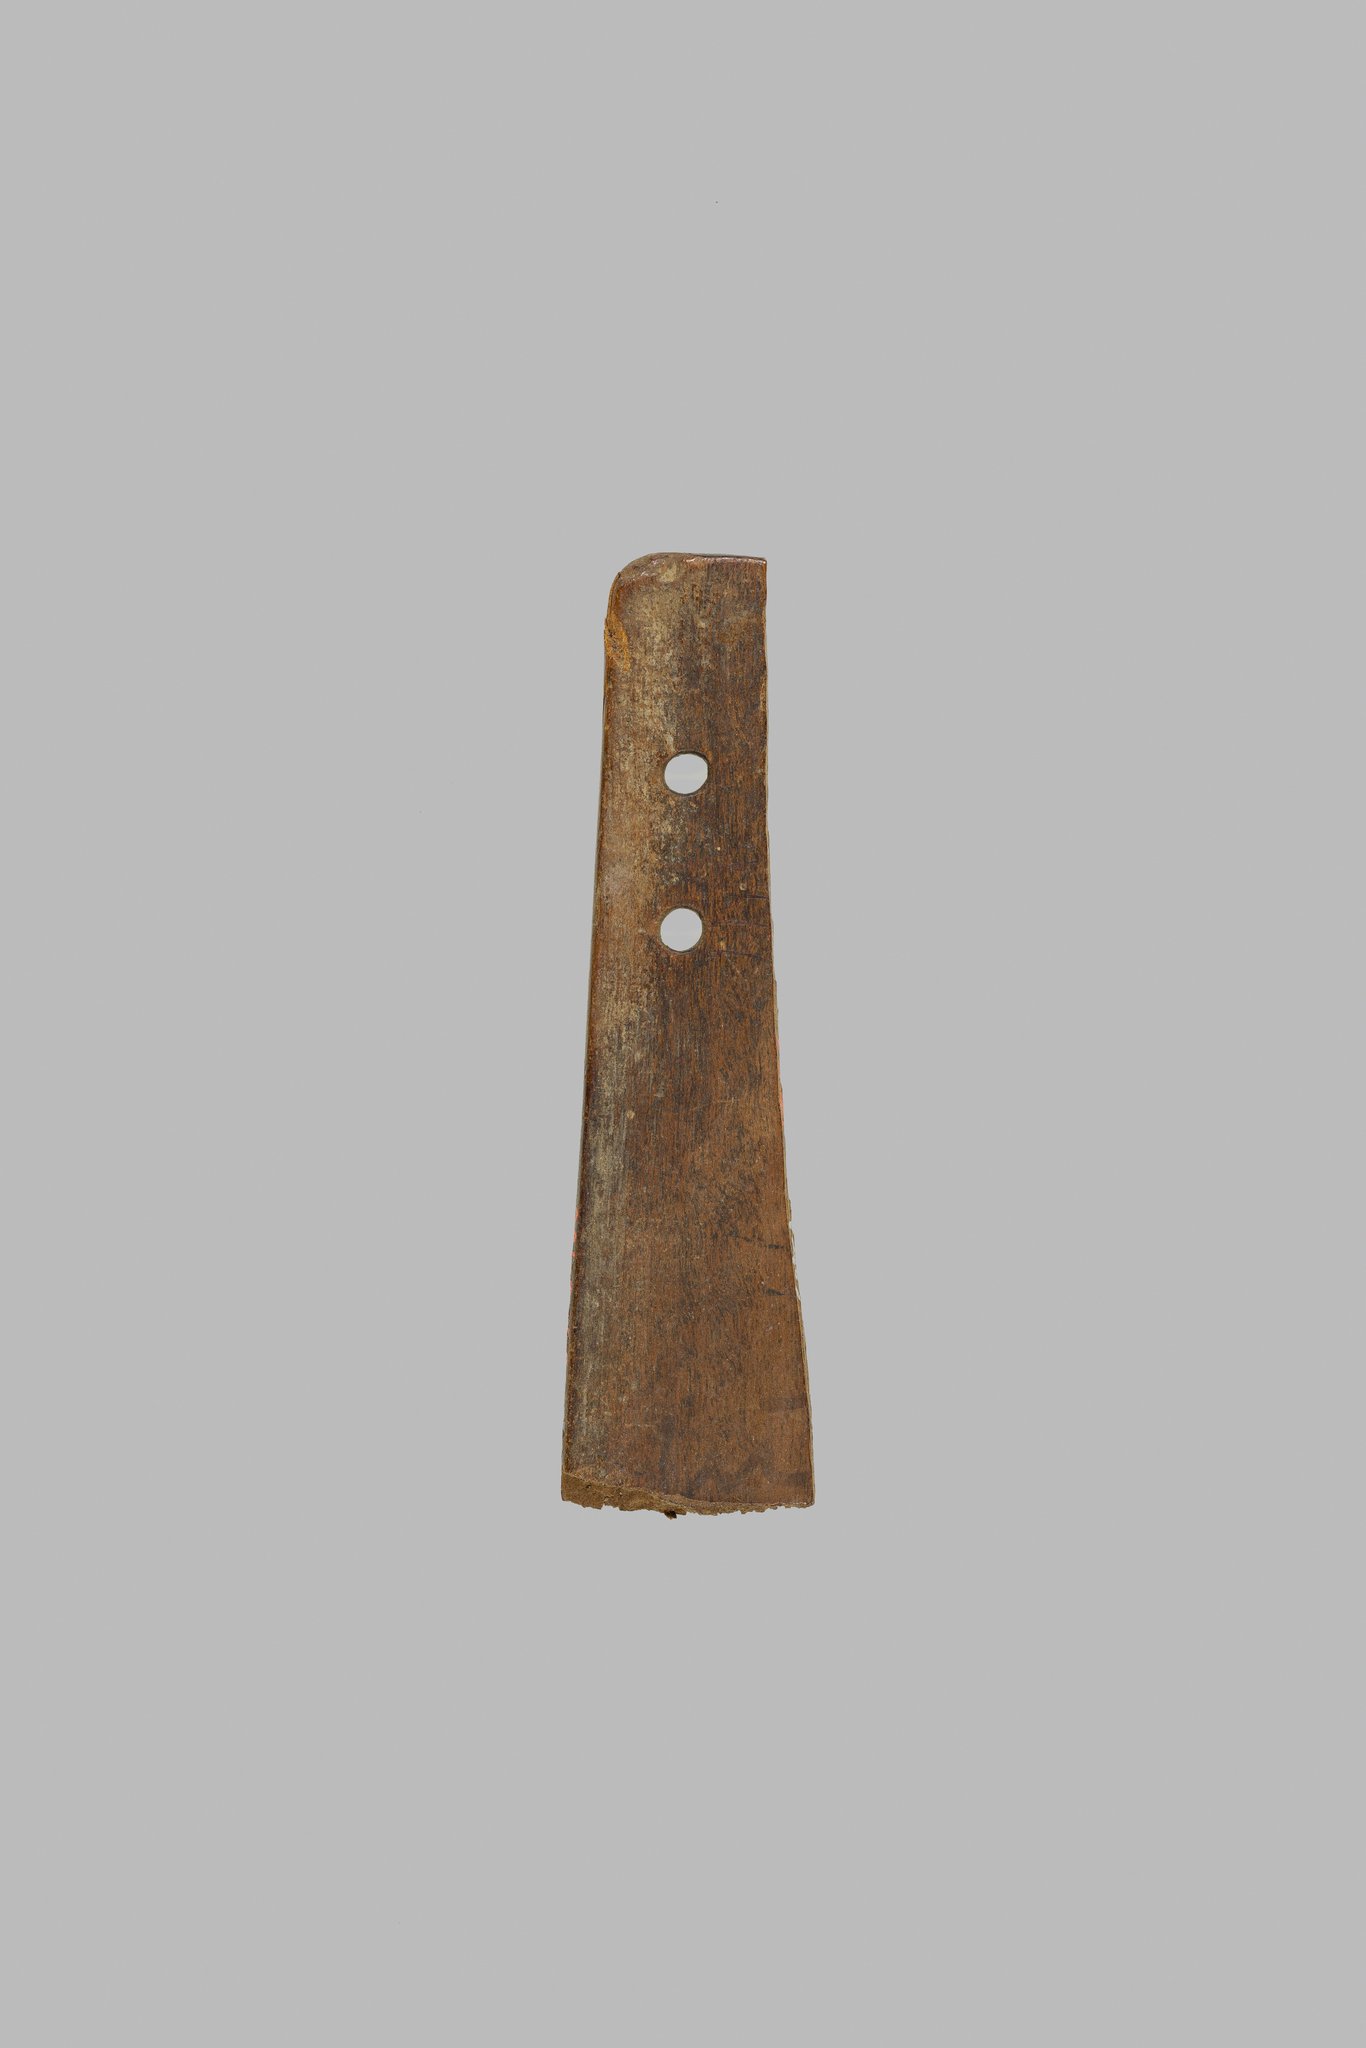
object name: mummy label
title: Fragment of a mummy label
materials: wood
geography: egypt